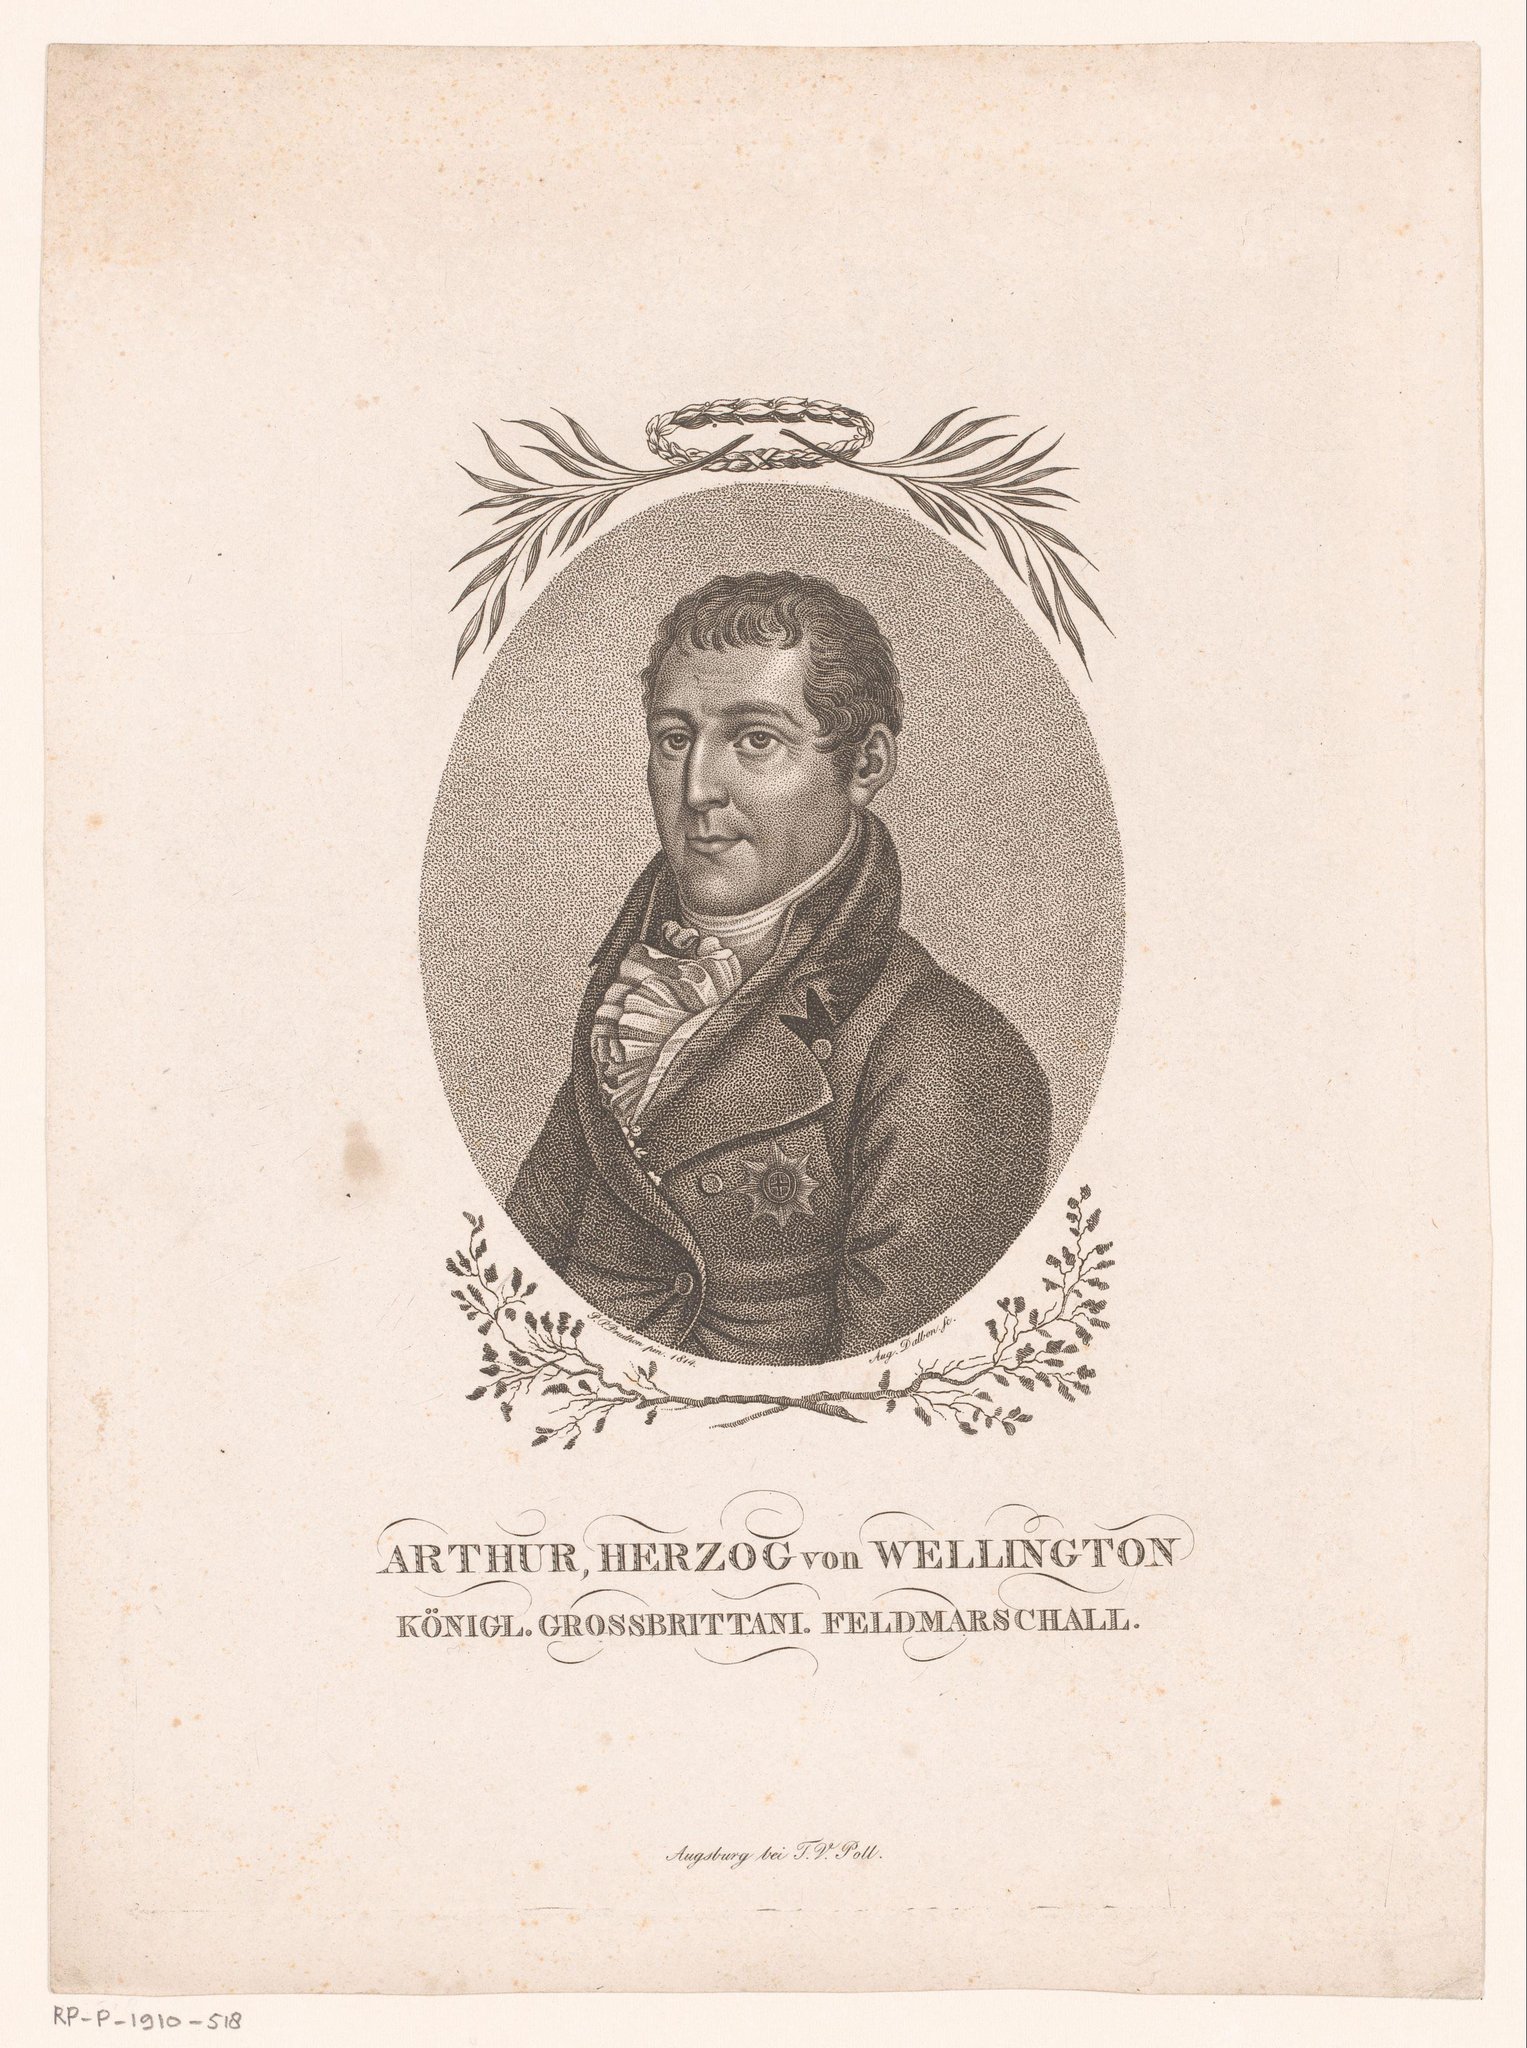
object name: print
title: Portret van Arthur Wellesley of Wellington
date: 1814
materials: paper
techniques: etching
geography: france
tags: walmer castle, arthur wellesley of wellington, historical persons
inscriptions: collector's mark: Lugt 2228